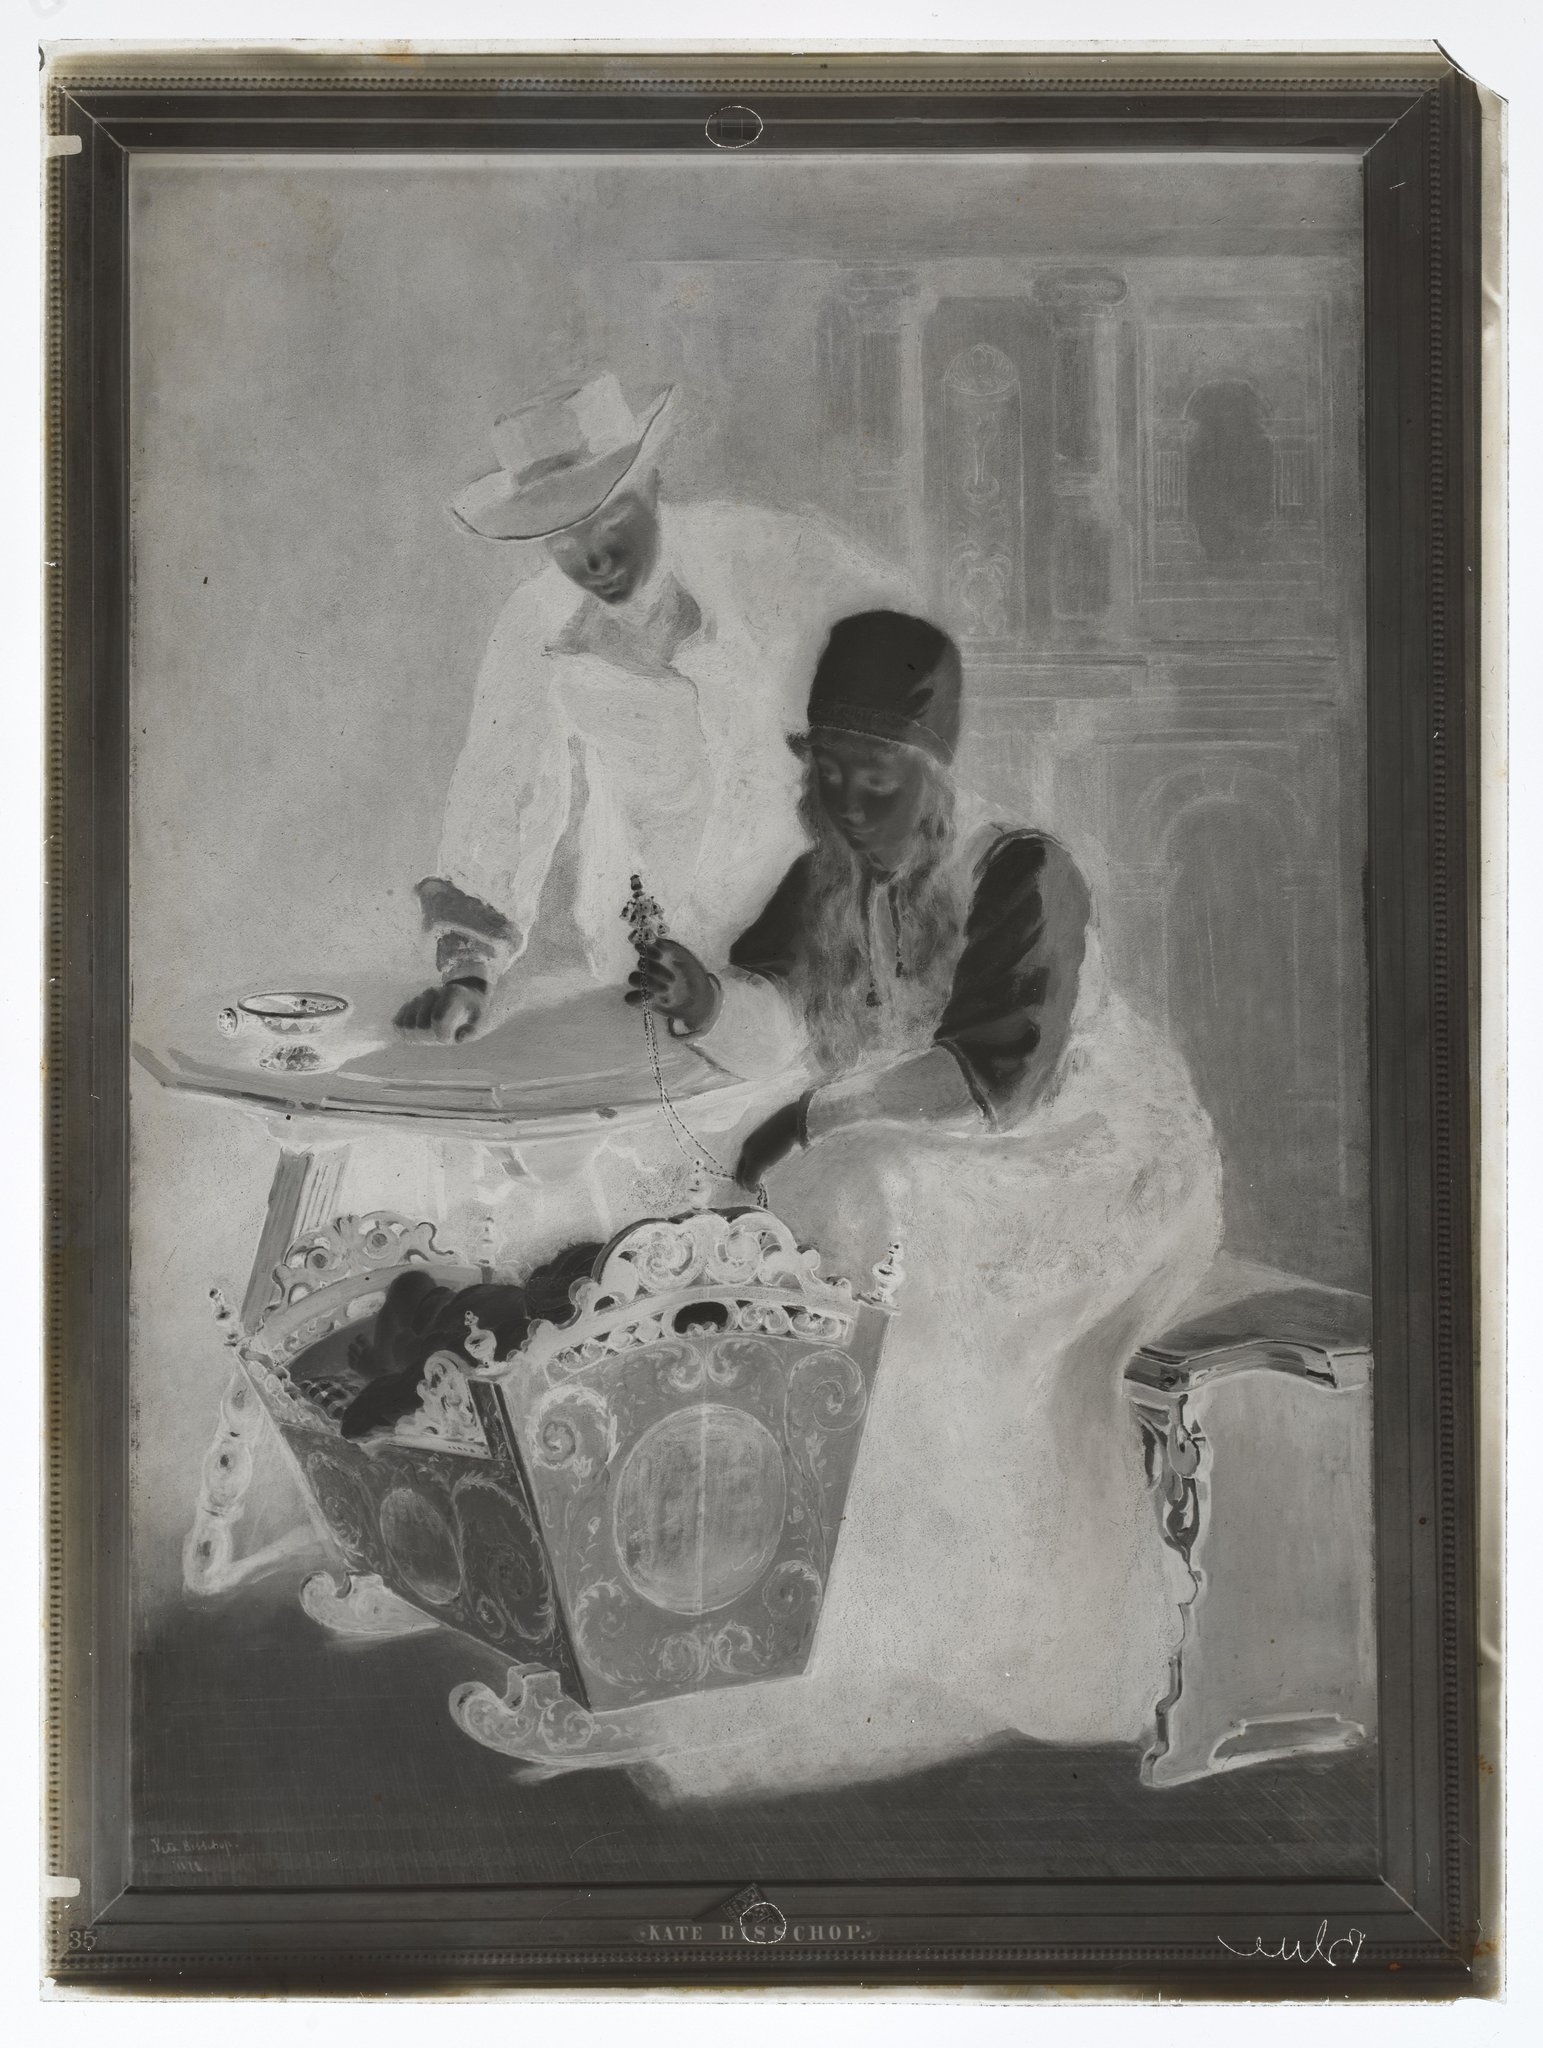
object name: reproduction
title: Fotoreproductie van het schilderij Jonge ouders door Kate Bisschop-Swift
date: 1890-1930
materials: glass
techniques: gelatin glass negative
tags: cradle, crib, parental love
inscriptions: inscription: ‘Blue’